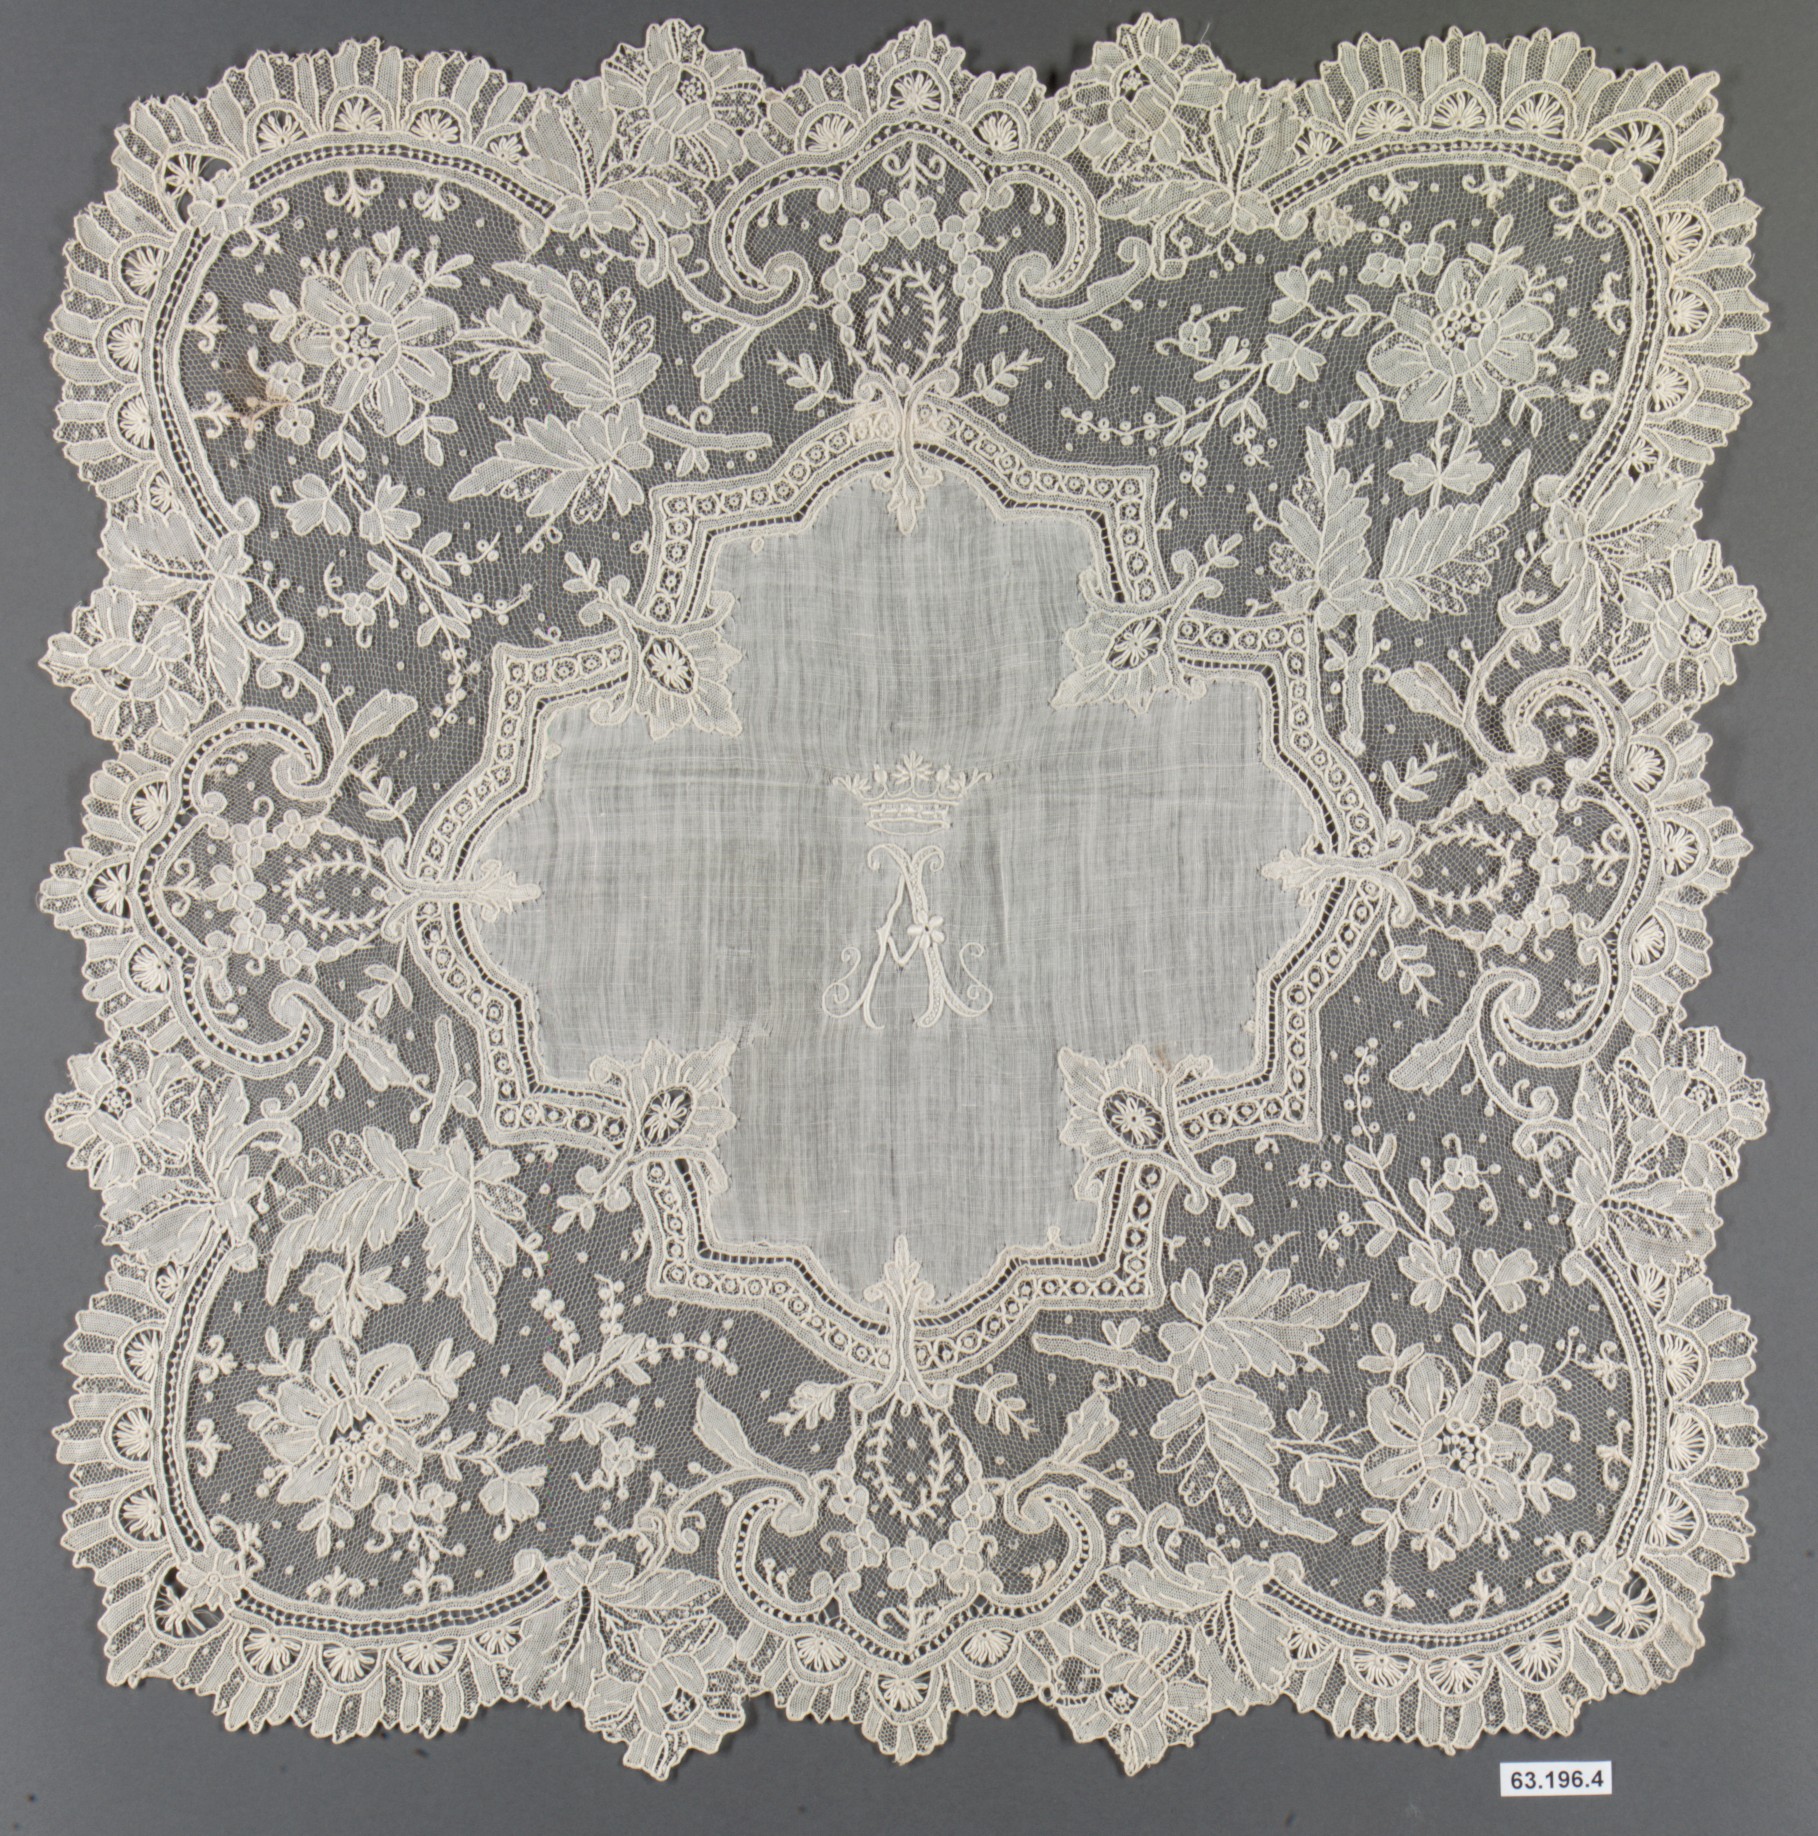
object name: handkerchief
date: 1875-1889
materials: linen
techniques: lace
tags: flowers